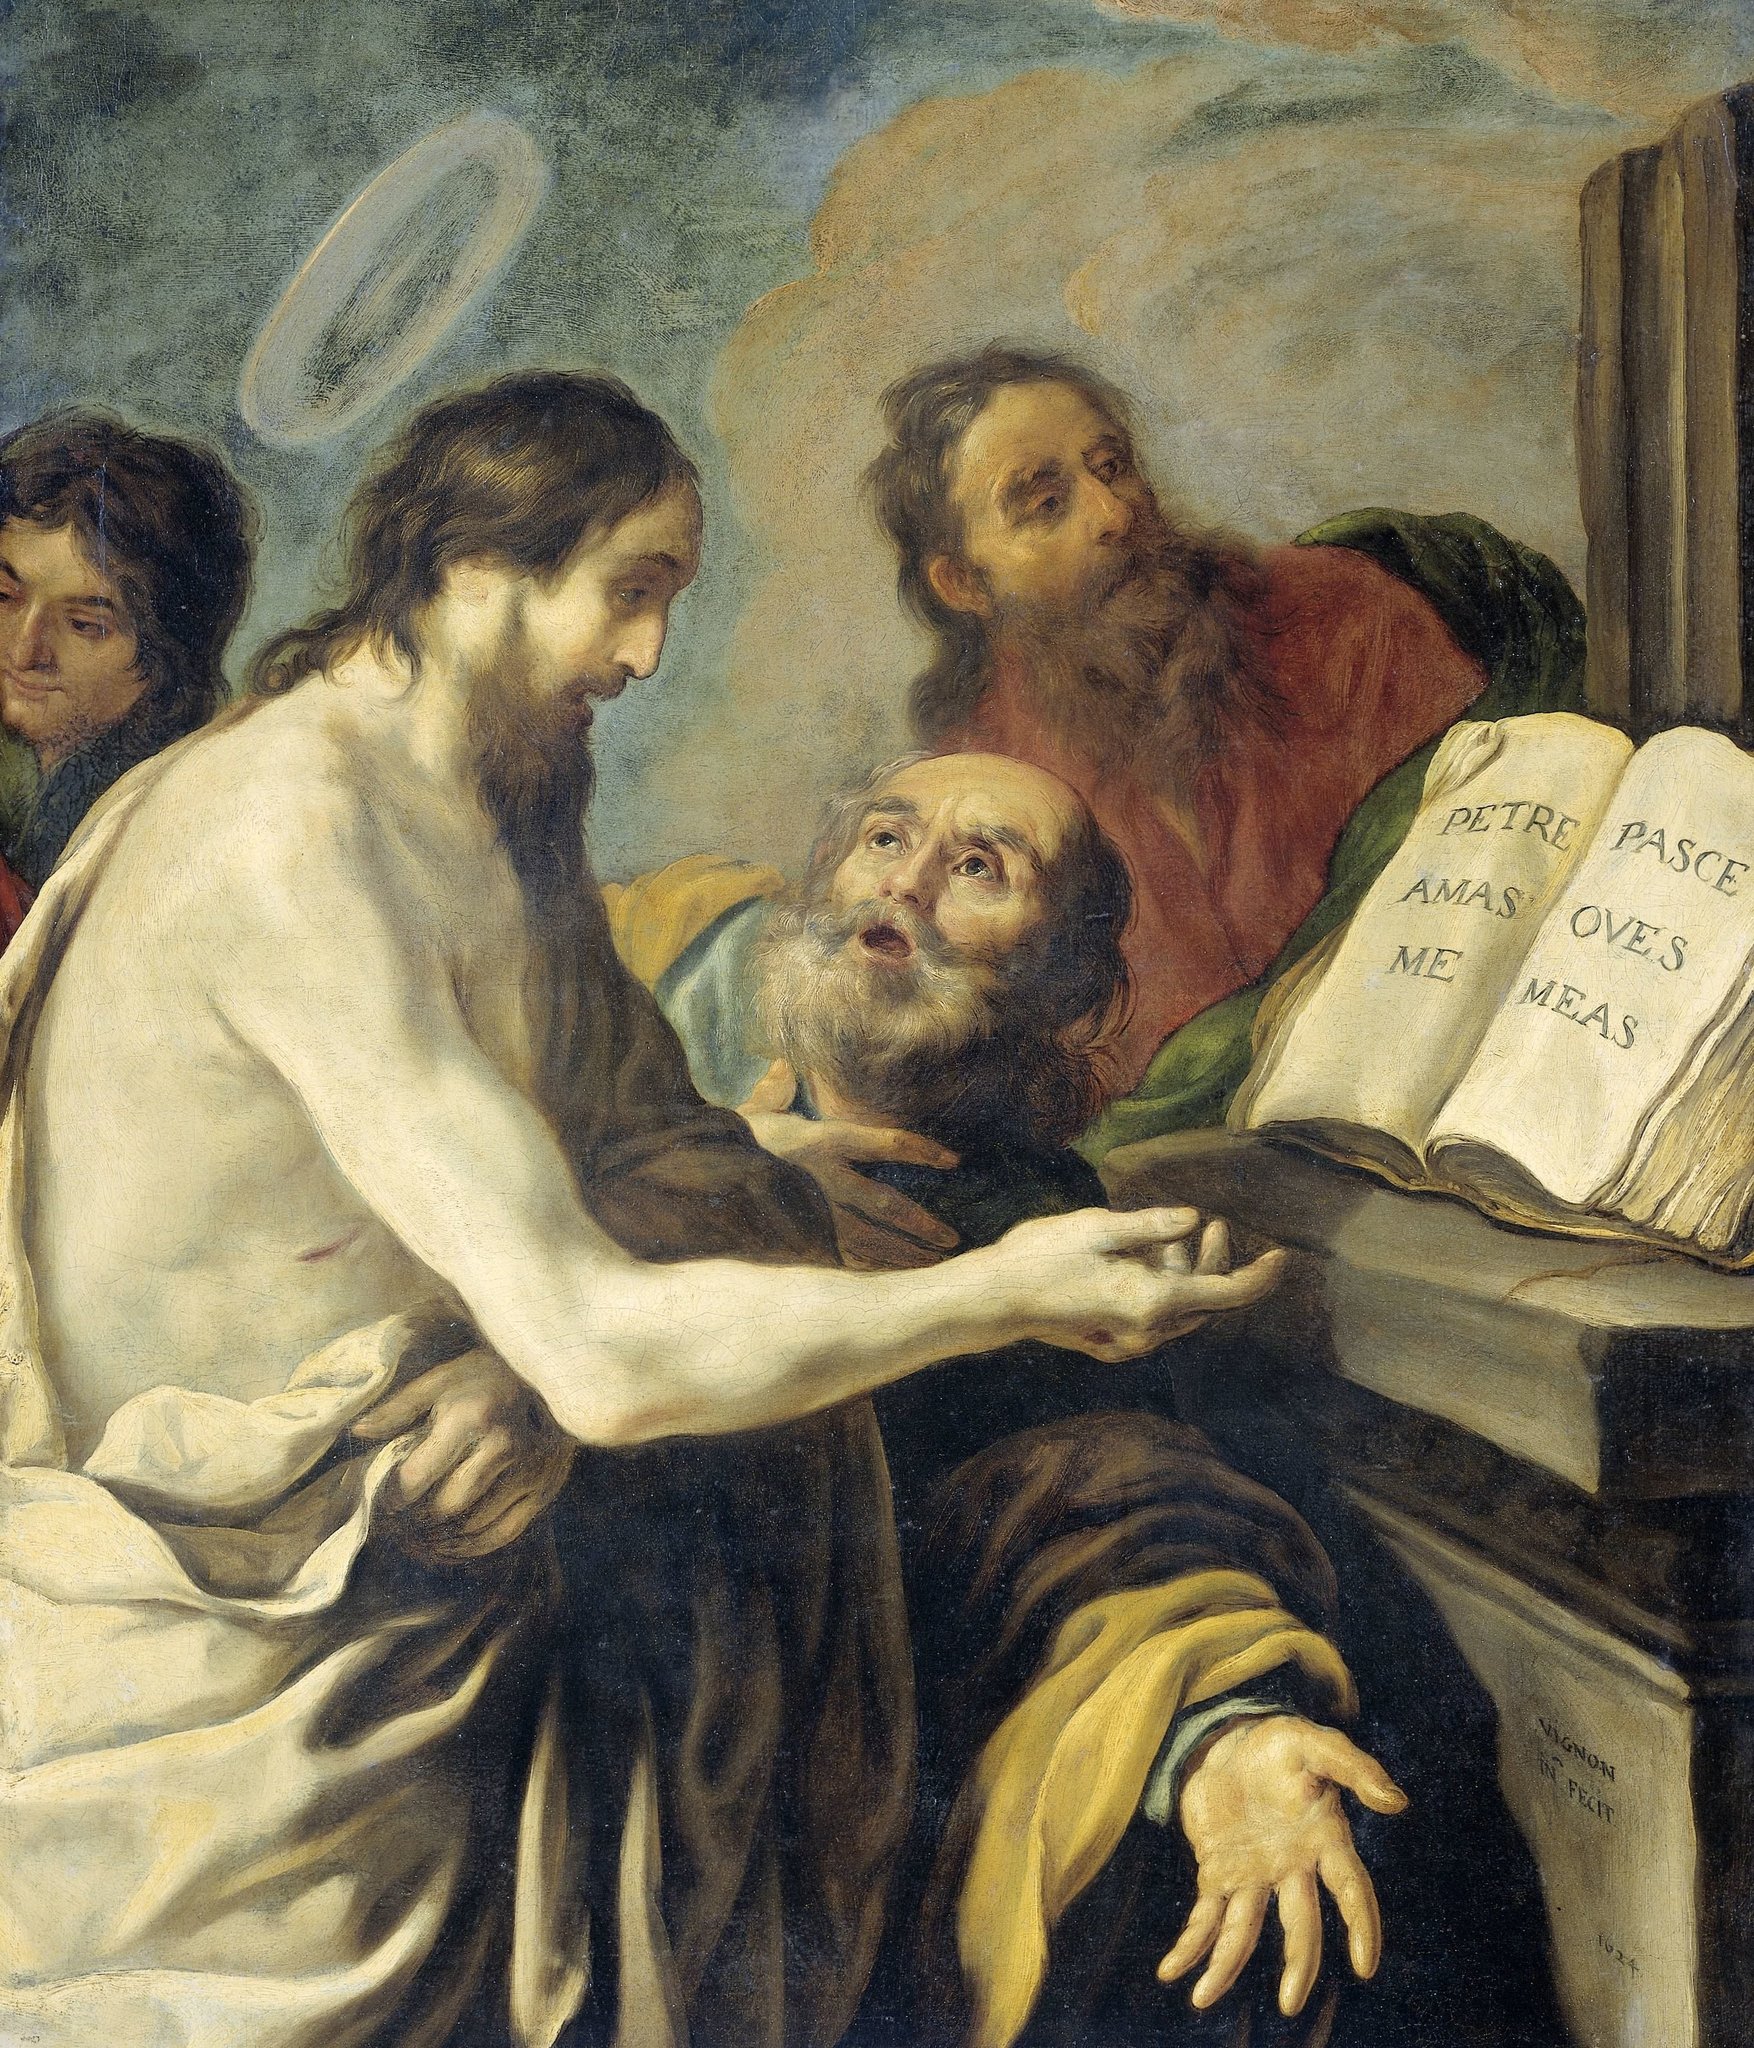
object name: painting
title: Christ Instructs Peter to Feed My Sheep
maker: claude vignon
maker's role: painter, print maker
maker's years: 1593-1670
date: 1624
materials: canvas, oil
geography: france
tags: mission of peter ('pasce oves meas'): christ pointing to a lamb, peter perhaps with keys in his hands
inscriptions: signature and date: ‘Vignon In. Fecit 1624’, inscription: ‘Petre Amas Me Pasce Oves Meas’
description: Christus draagt Petrus op: 'Weid mijn schapen'. Christus gebaart naar een opengeslagen boek waarin de woorden staan 'Petre Amas Me Pasce Oves Meas' (Johannes 21: 15-23). Petrus heeft zich naar Christus gekeerd, op de achtergrond twee andere discipelen.